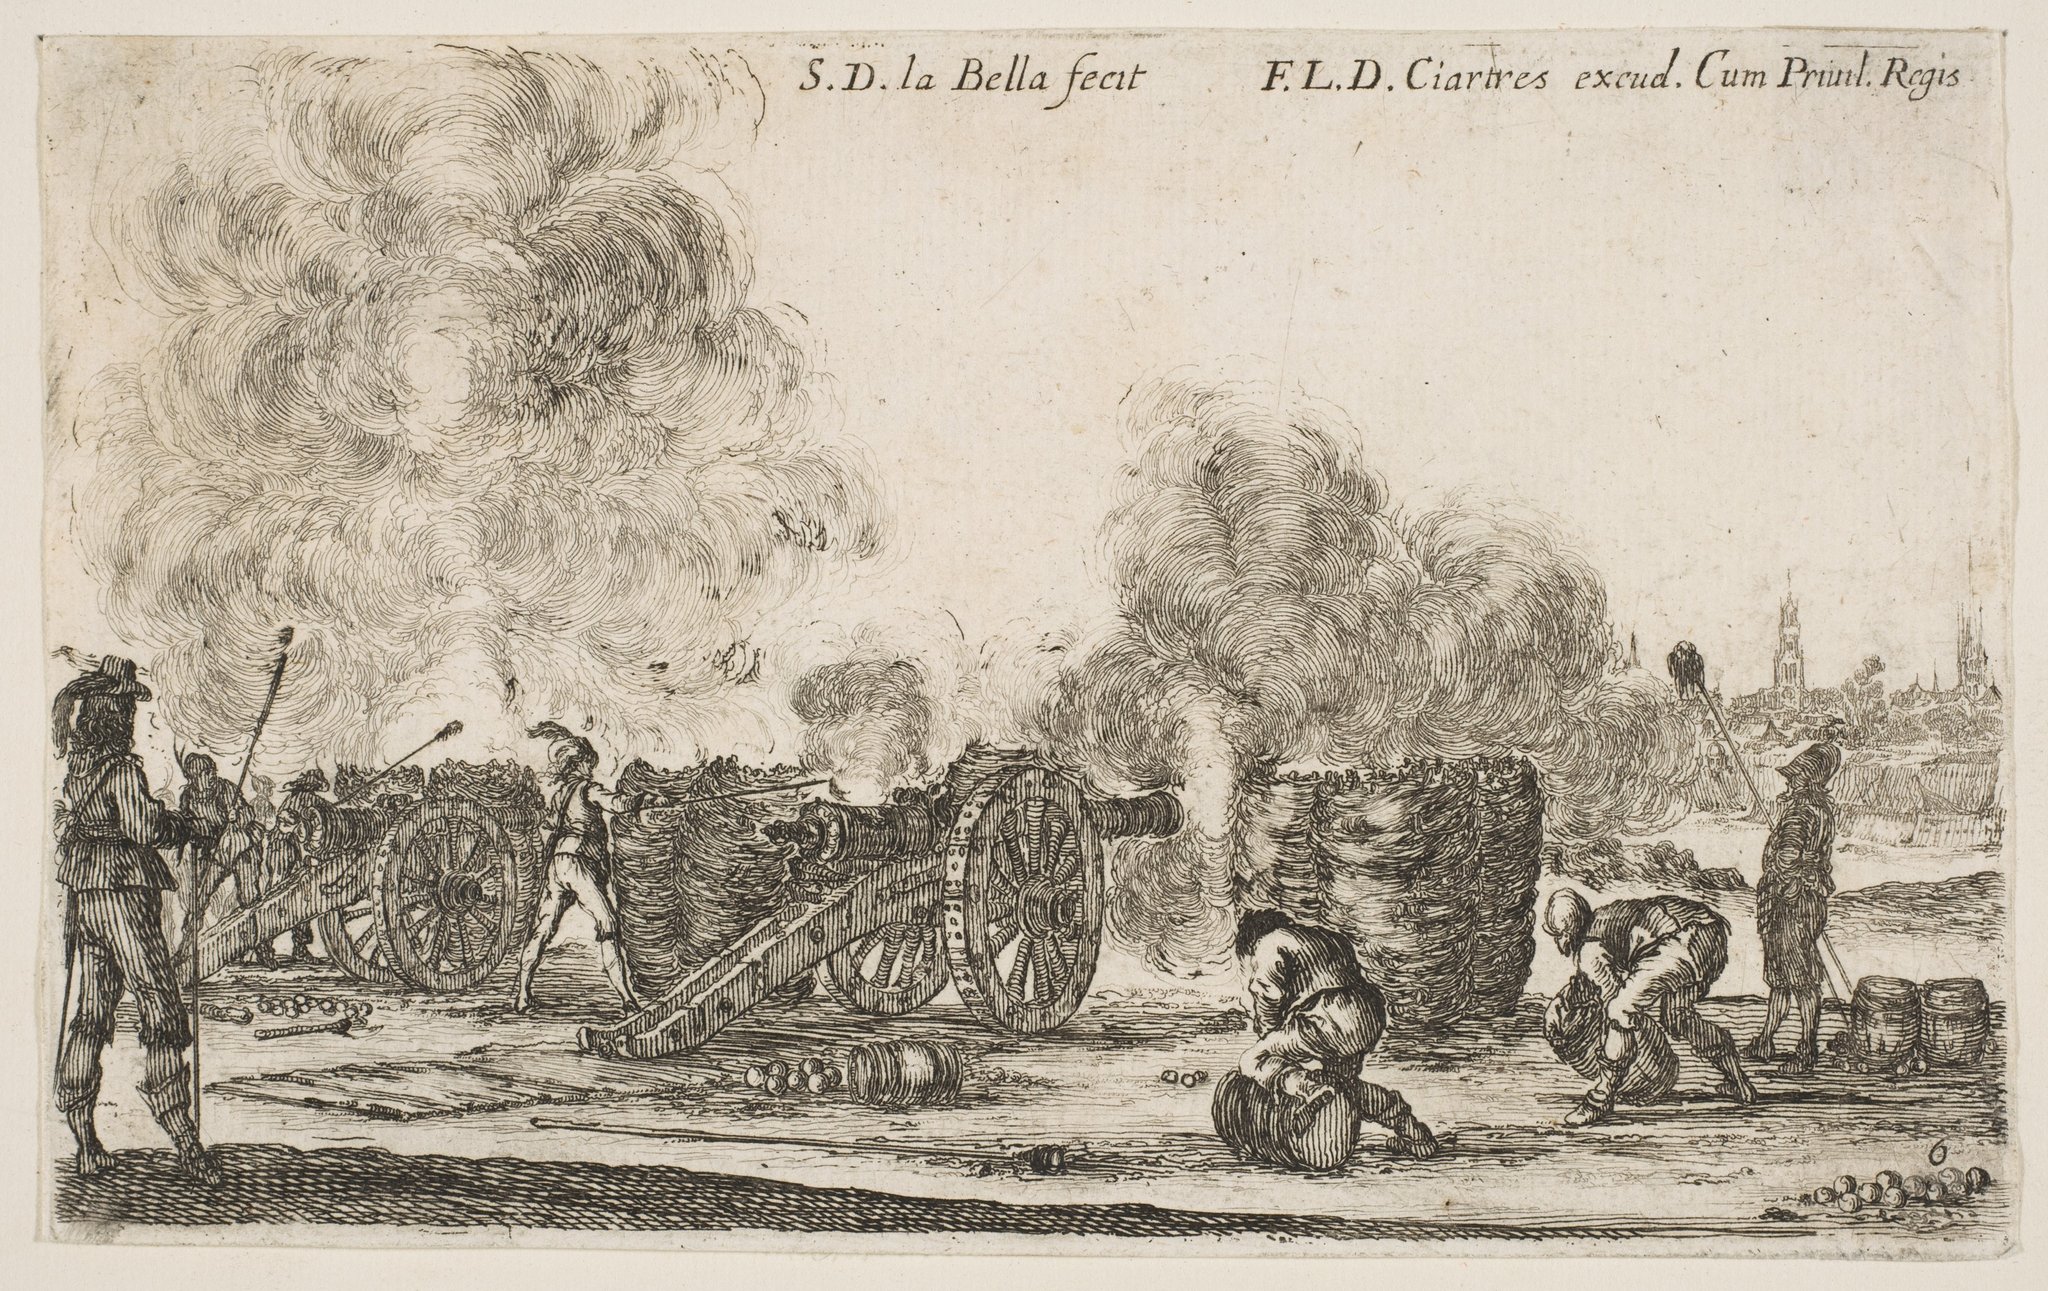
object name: print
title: Battery of cannons firing on a city, plate 6 from "Various Military Caprices" (Varii capricci militari)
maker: stefano della bella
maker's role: artist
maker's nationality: italian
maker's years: 1610-1664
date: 1641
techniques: etching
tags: battles,military,cannons,men